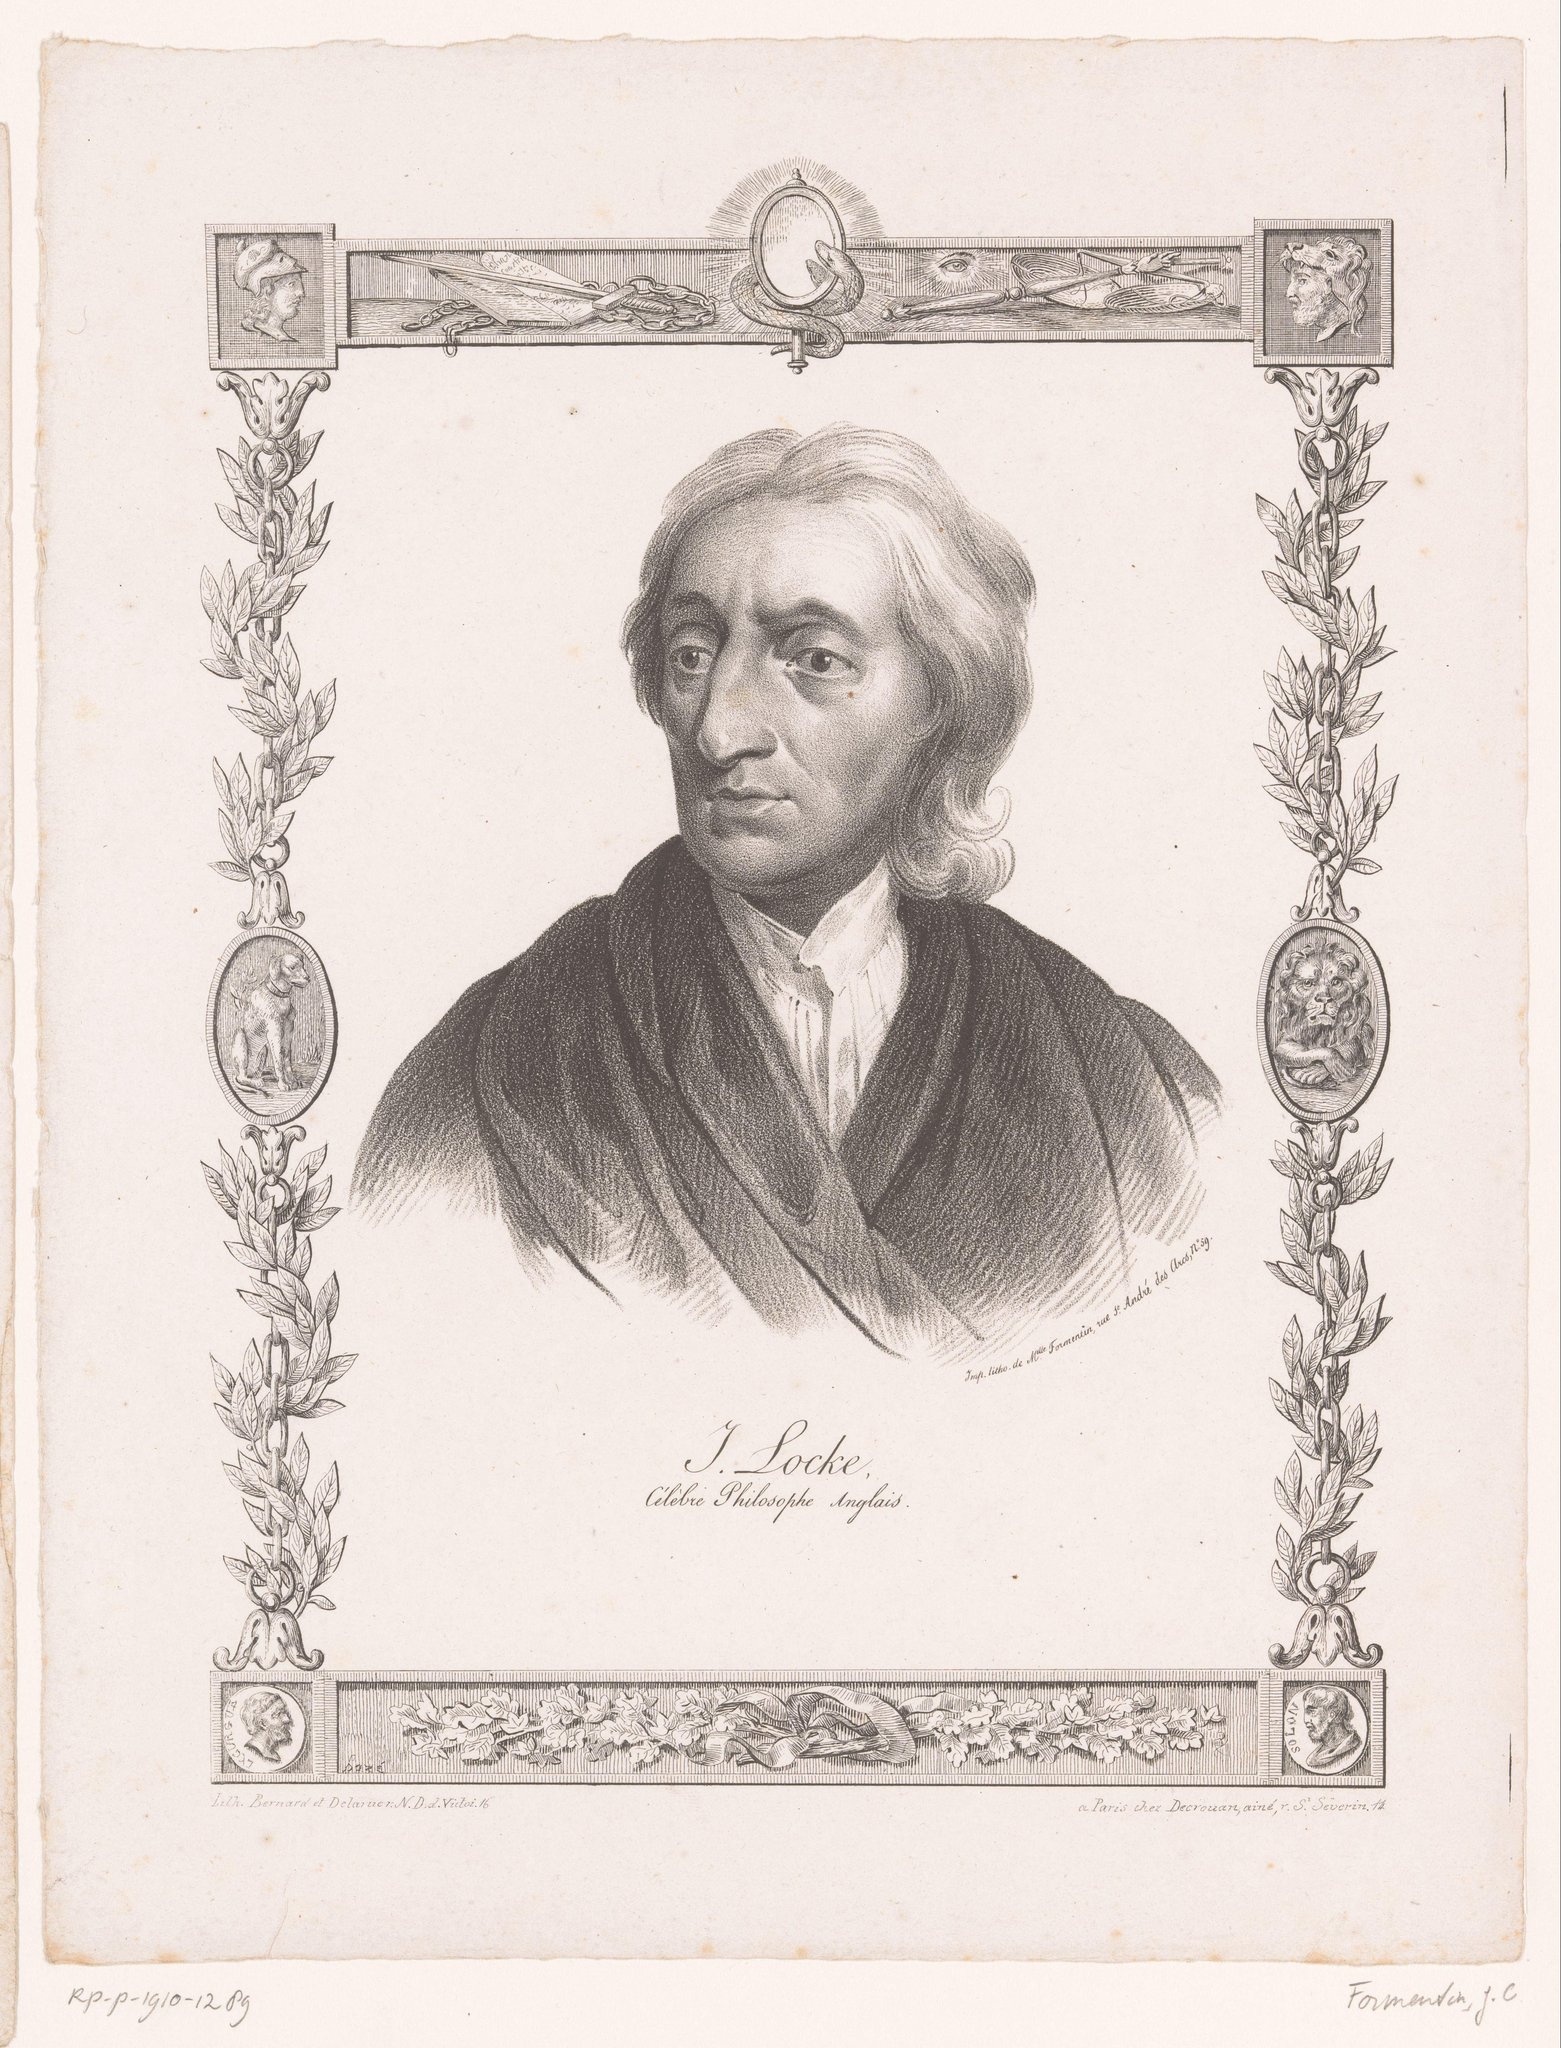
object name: print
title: J. Locke, Célèbre Philosophe Anglais.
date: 1826-1829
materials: paper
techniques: lithograph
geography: paris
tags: physicist, historical persons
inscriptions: collector's mark: Lugt 2228a